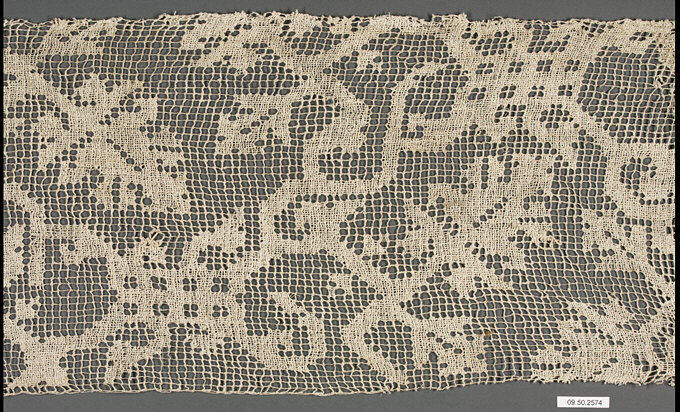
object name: strip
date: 1601-1700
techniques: embroidery